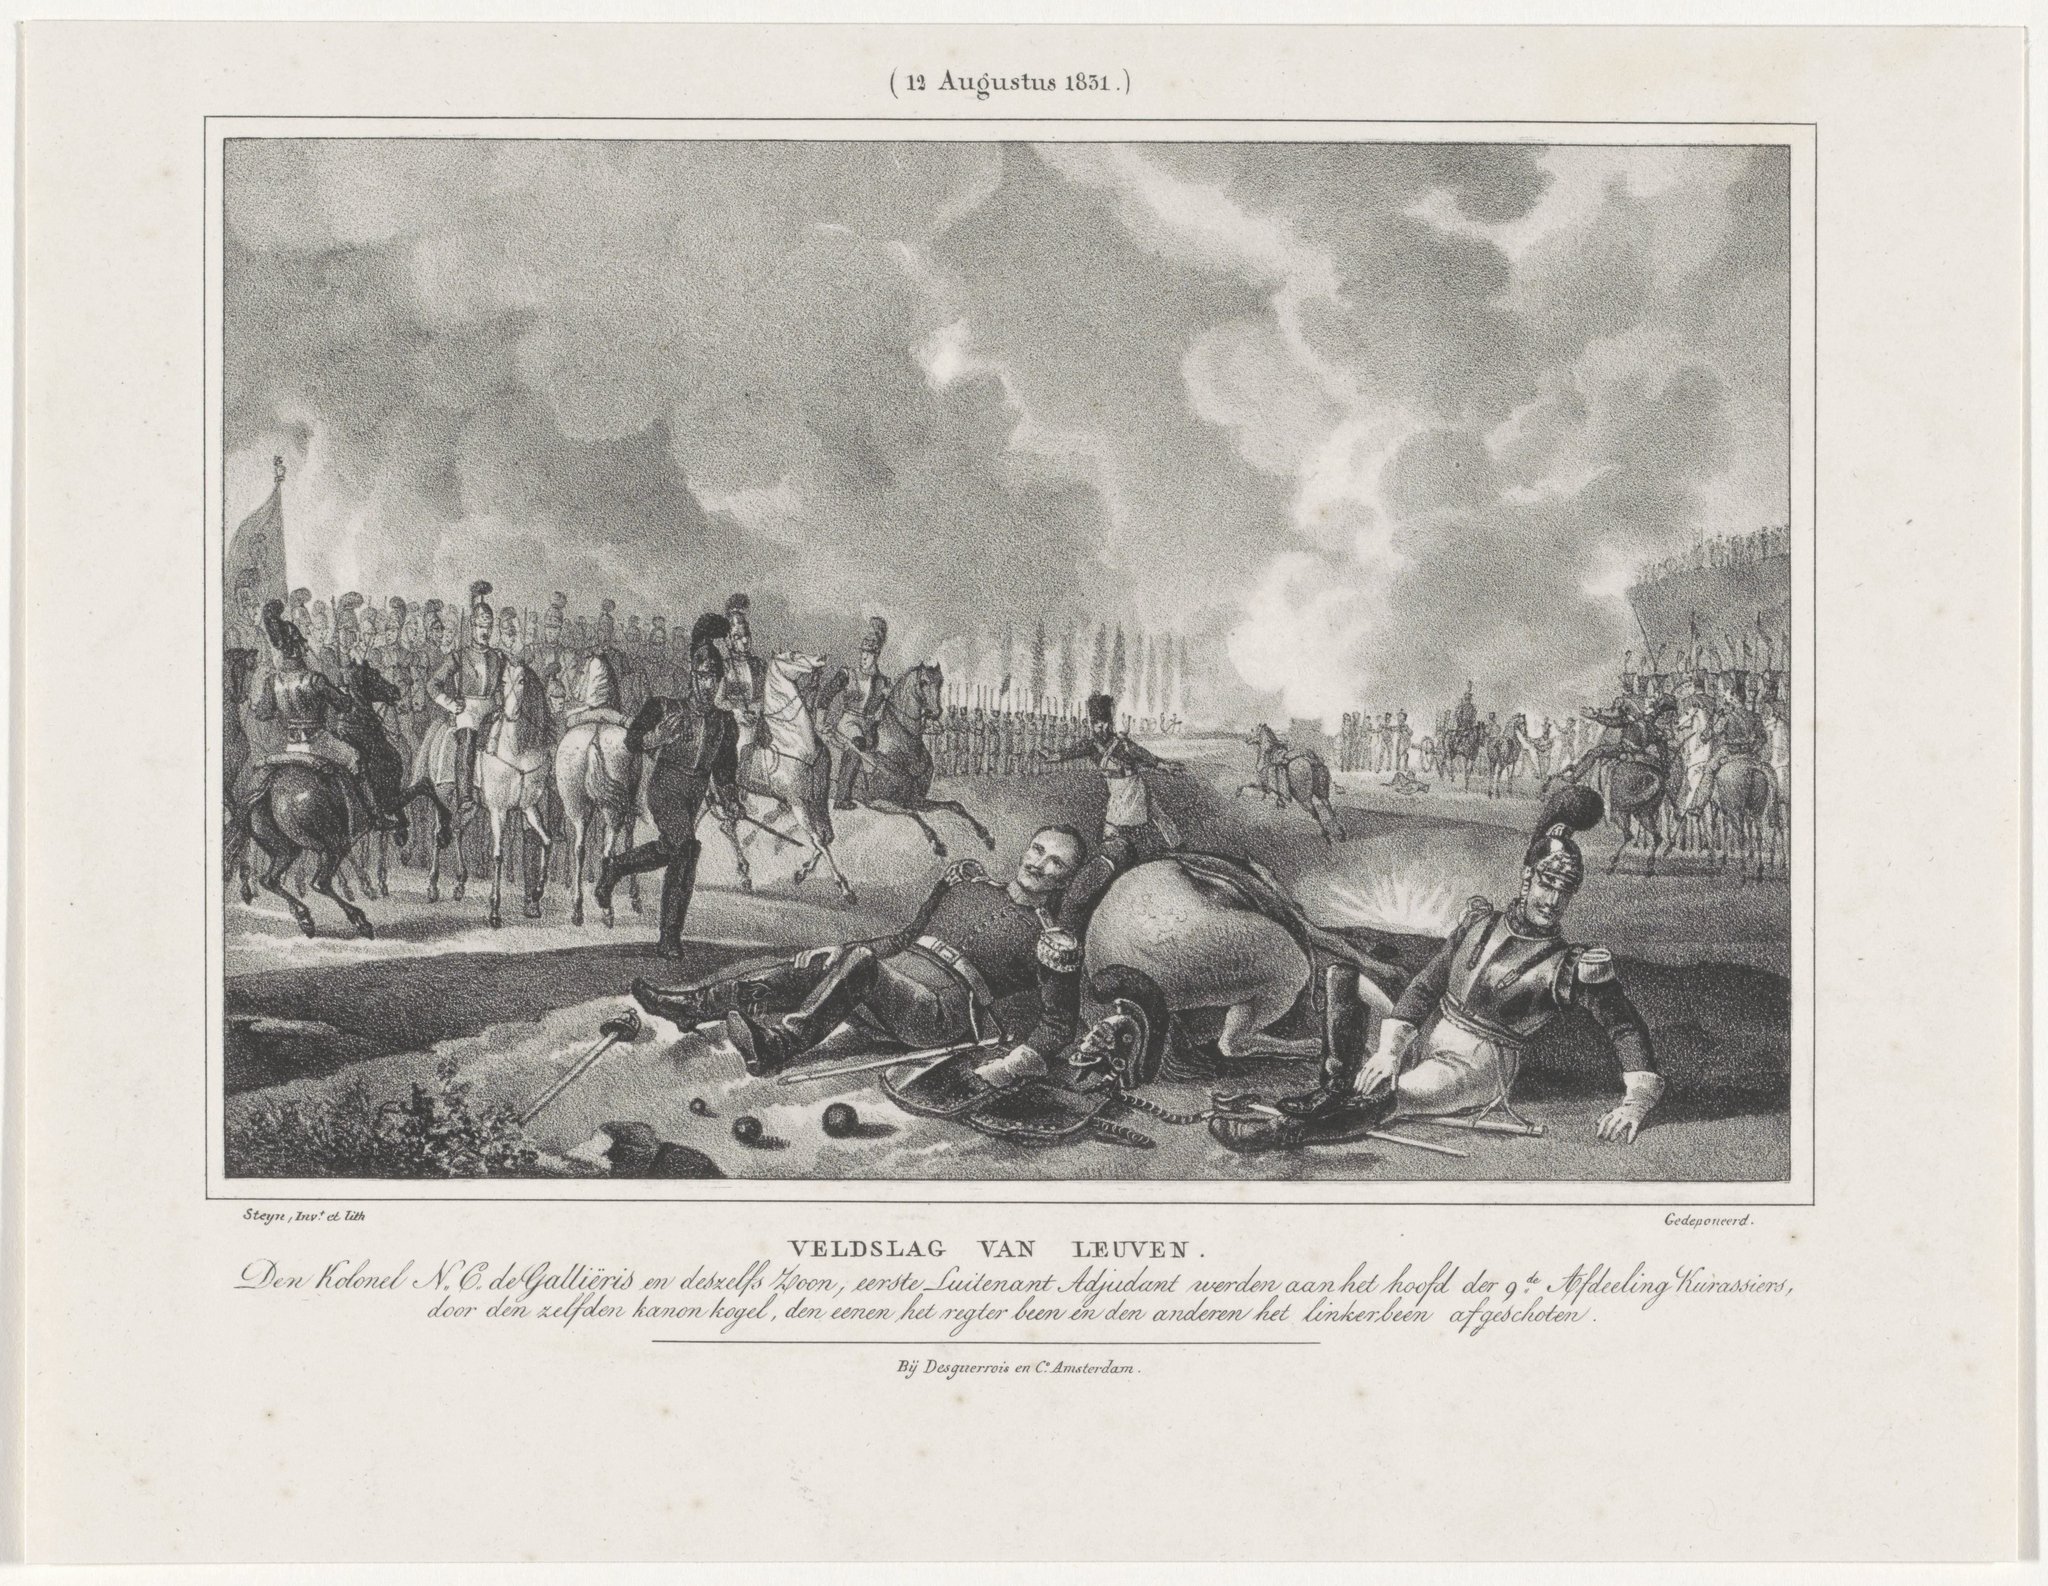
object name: print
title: Veldslag van Leuven. Den Kolonel N.C. de Galliëris en deszelfs Zoon, eerste Luitenant Adjudant werden aan het hoofd der 9de Afdeeling Kurassiers, door den zelfde kanon kogel, den eenen het regter been en den anderen het linkerbeen afgeschoten / (12 Augustus 1831)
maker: johannes steyn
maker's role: print maker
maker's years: 1805-1840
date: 1831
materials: paper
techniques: lithograph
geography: netherlands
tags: battle (+ land forces), louvain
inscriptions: collector's mark: Lugt 2228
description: Tijdens de slag bij Leuven raken de kolonel N.C. de Gallières en zijn zoon, beiden van de 9e Afdeling Kurassiers, gewond, op 12 augustus 1831. Onderdeel van een serie van zeven platen.